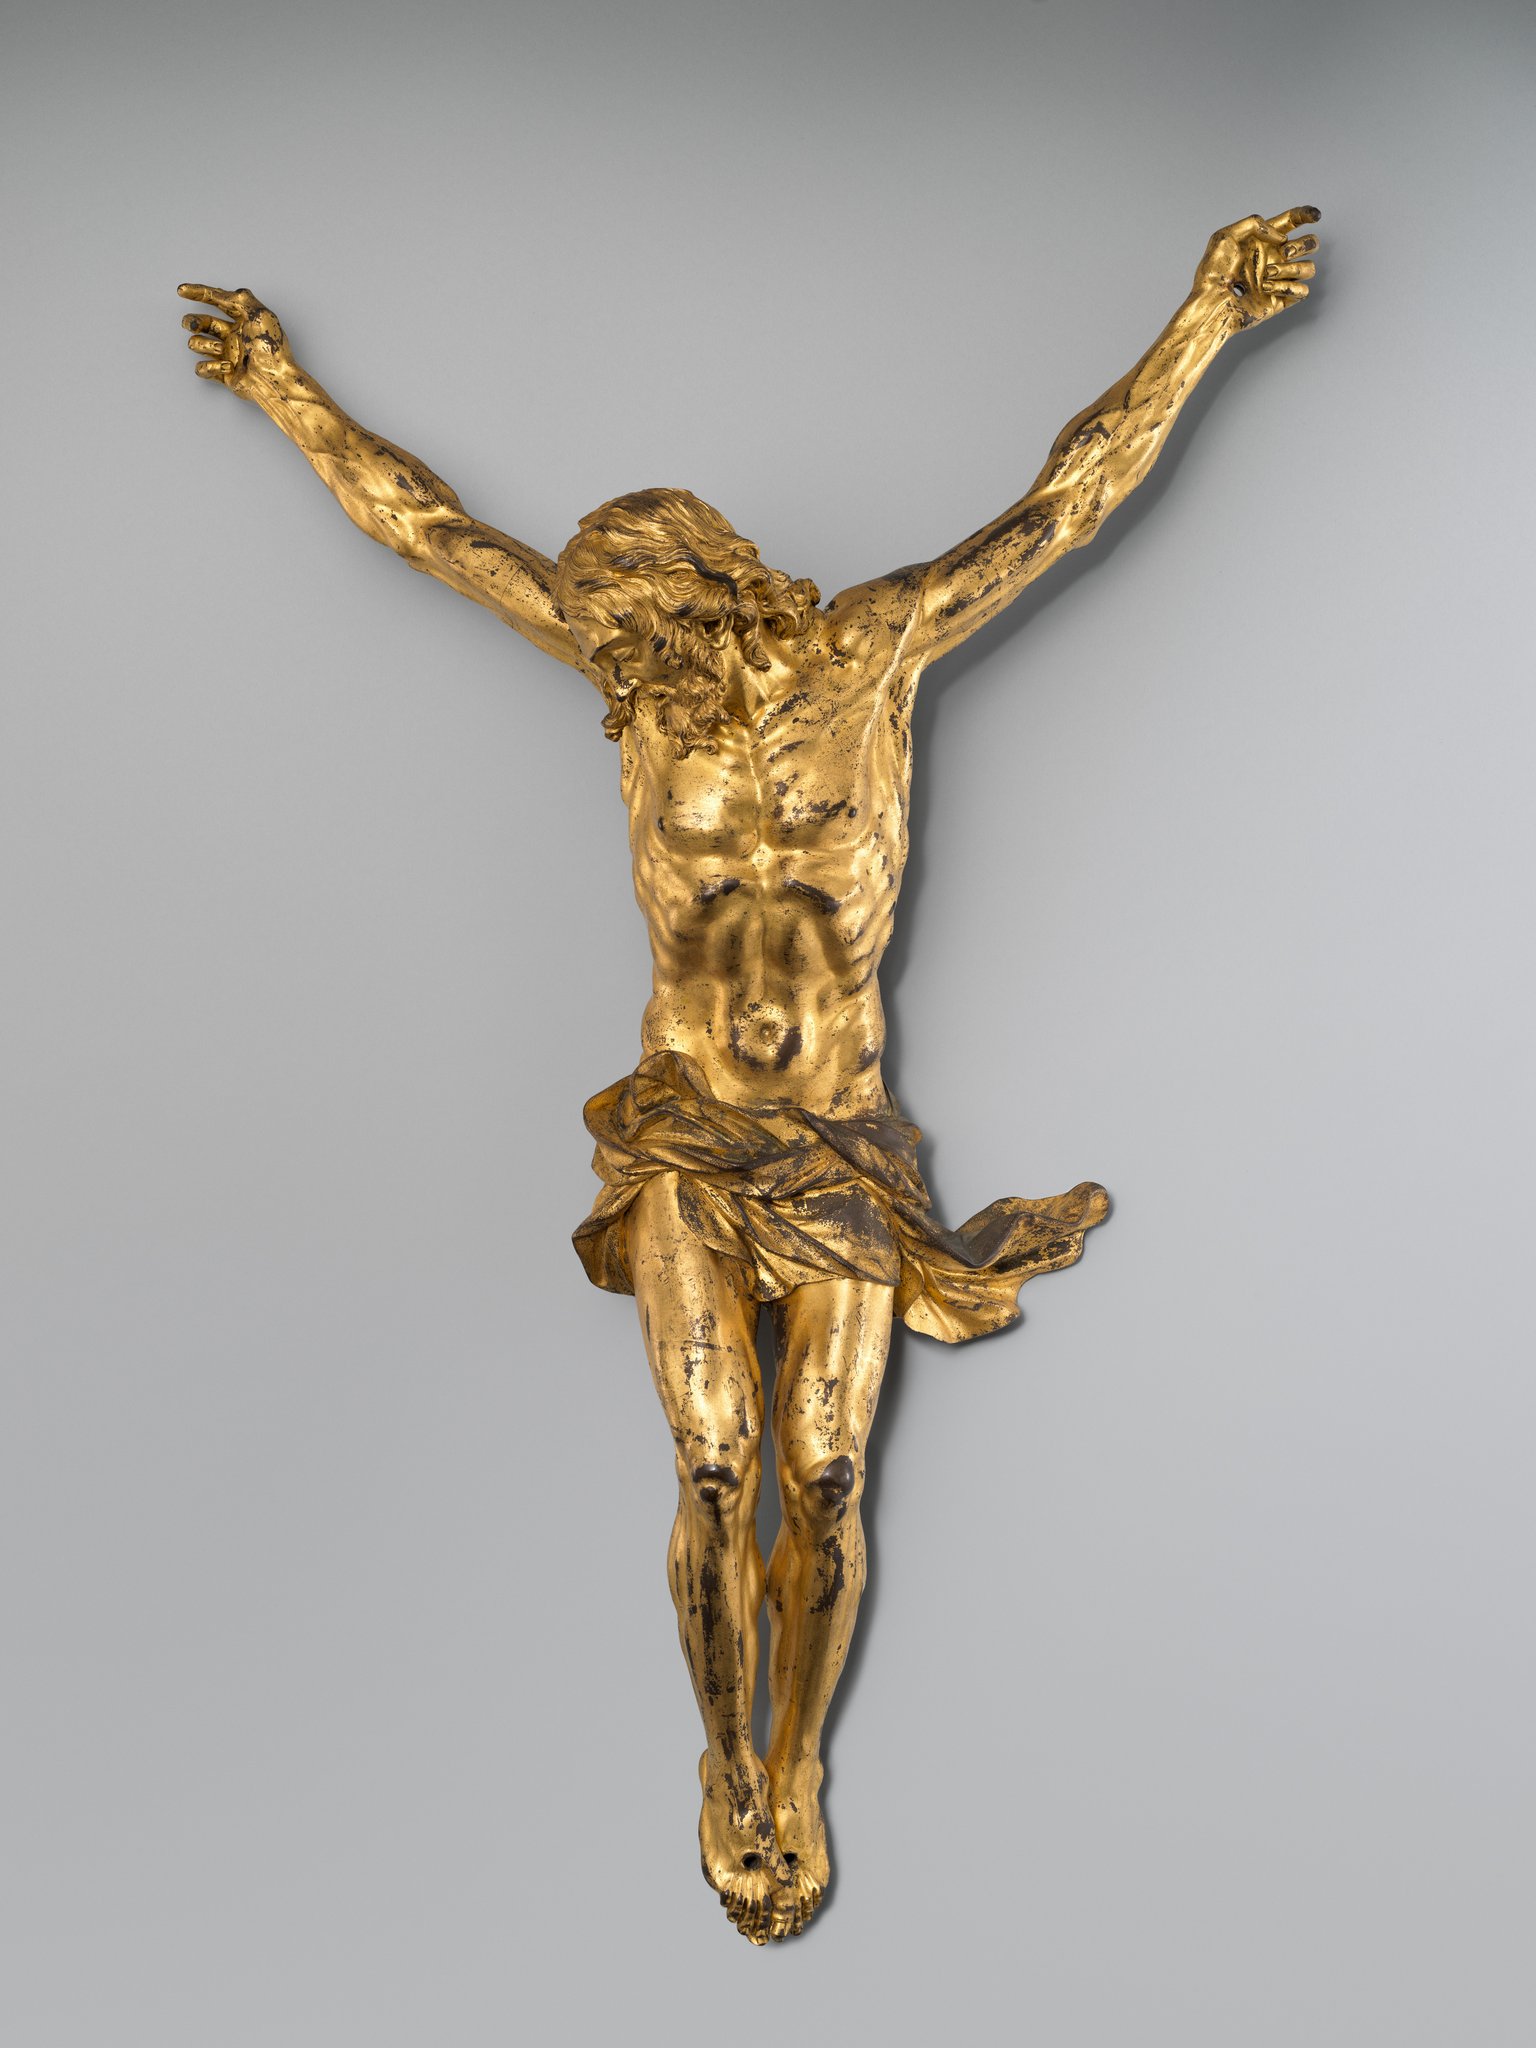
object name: corpus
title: Corpus from a crucifix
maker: Anonymous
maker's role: artist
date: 1651-1700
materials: bronze, gilt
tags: christ,crucifixion